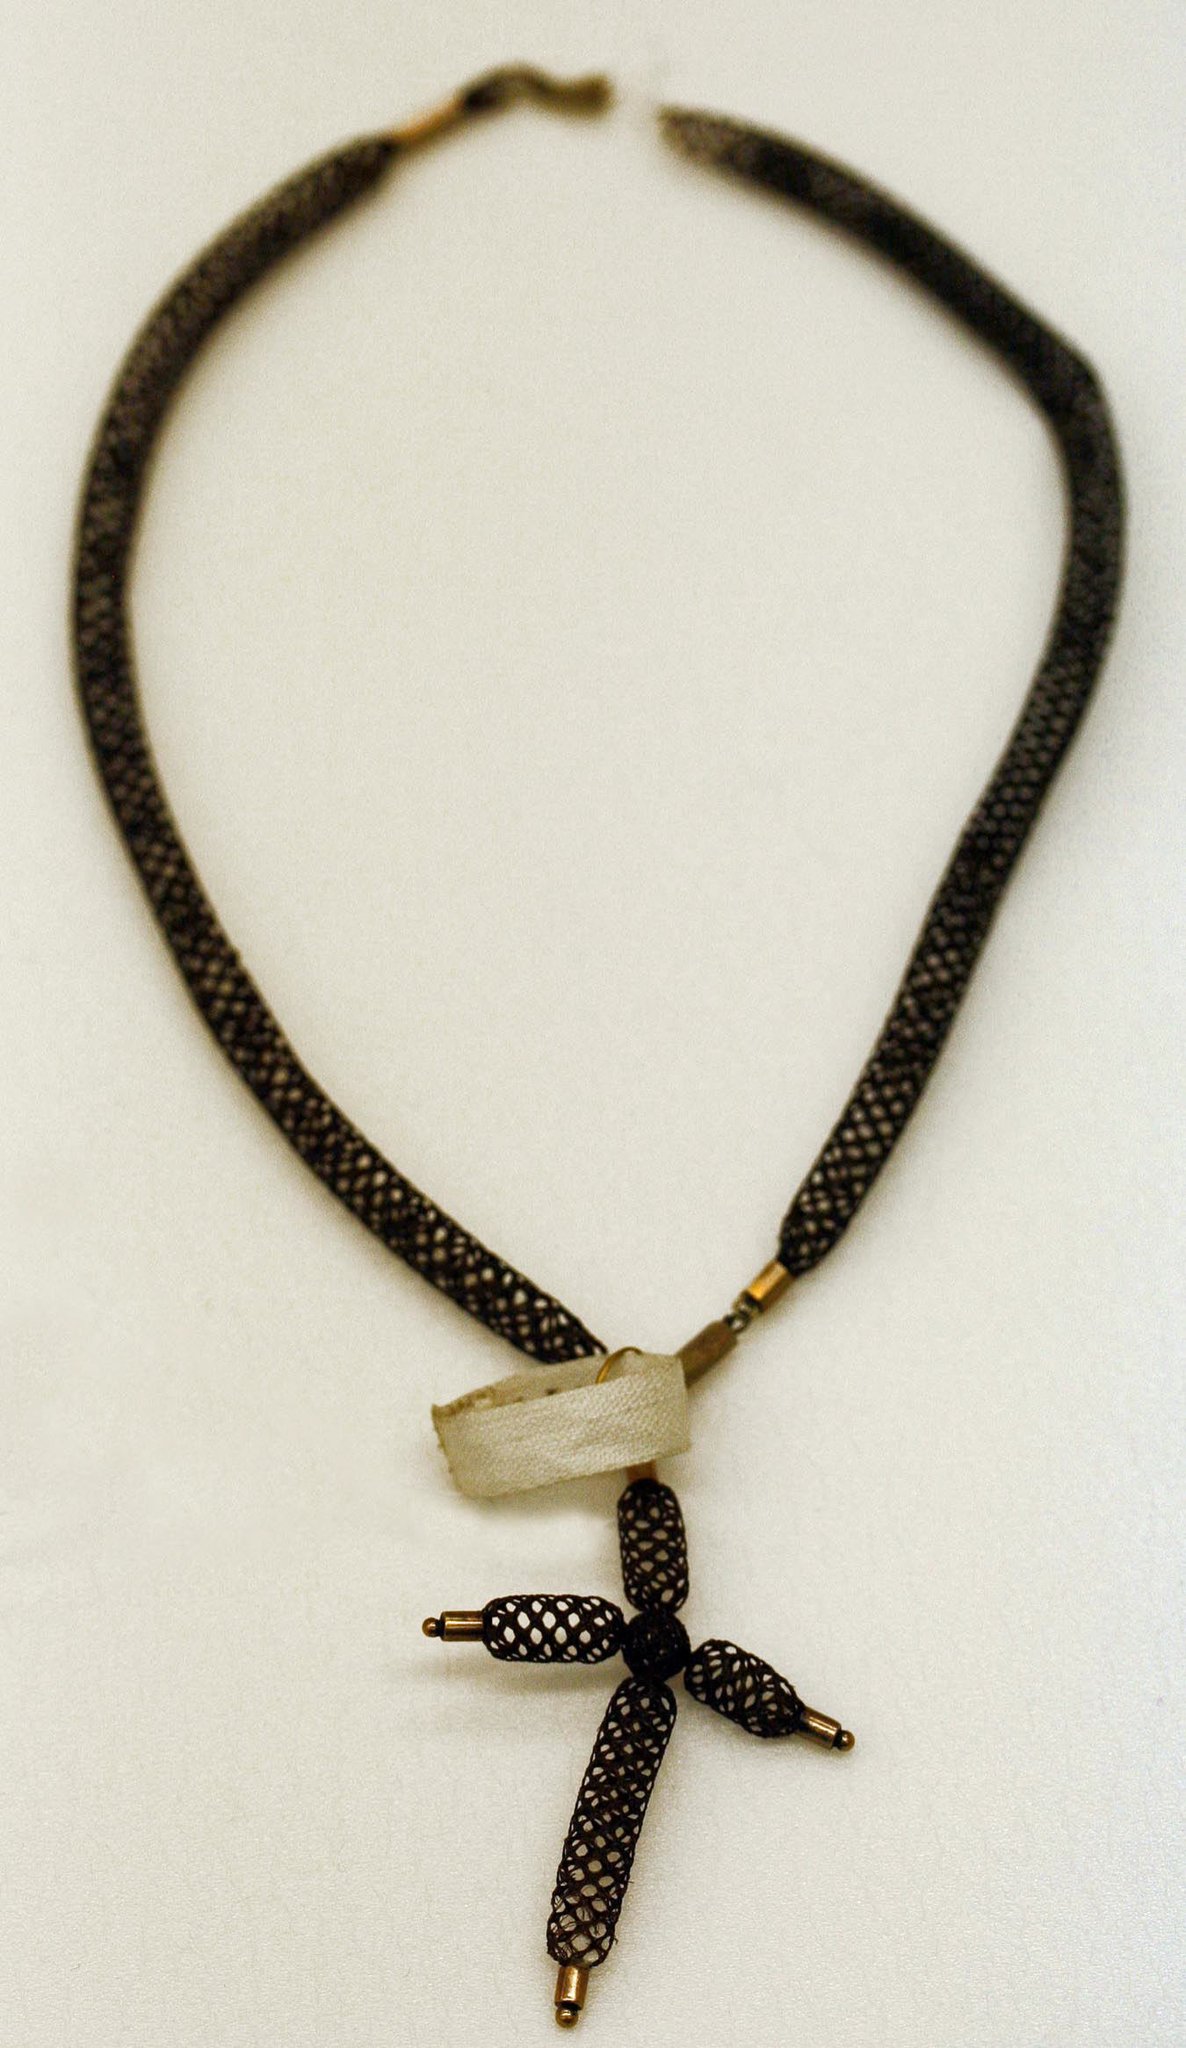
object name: necklace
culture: american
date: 1860-1870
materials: hair, metal